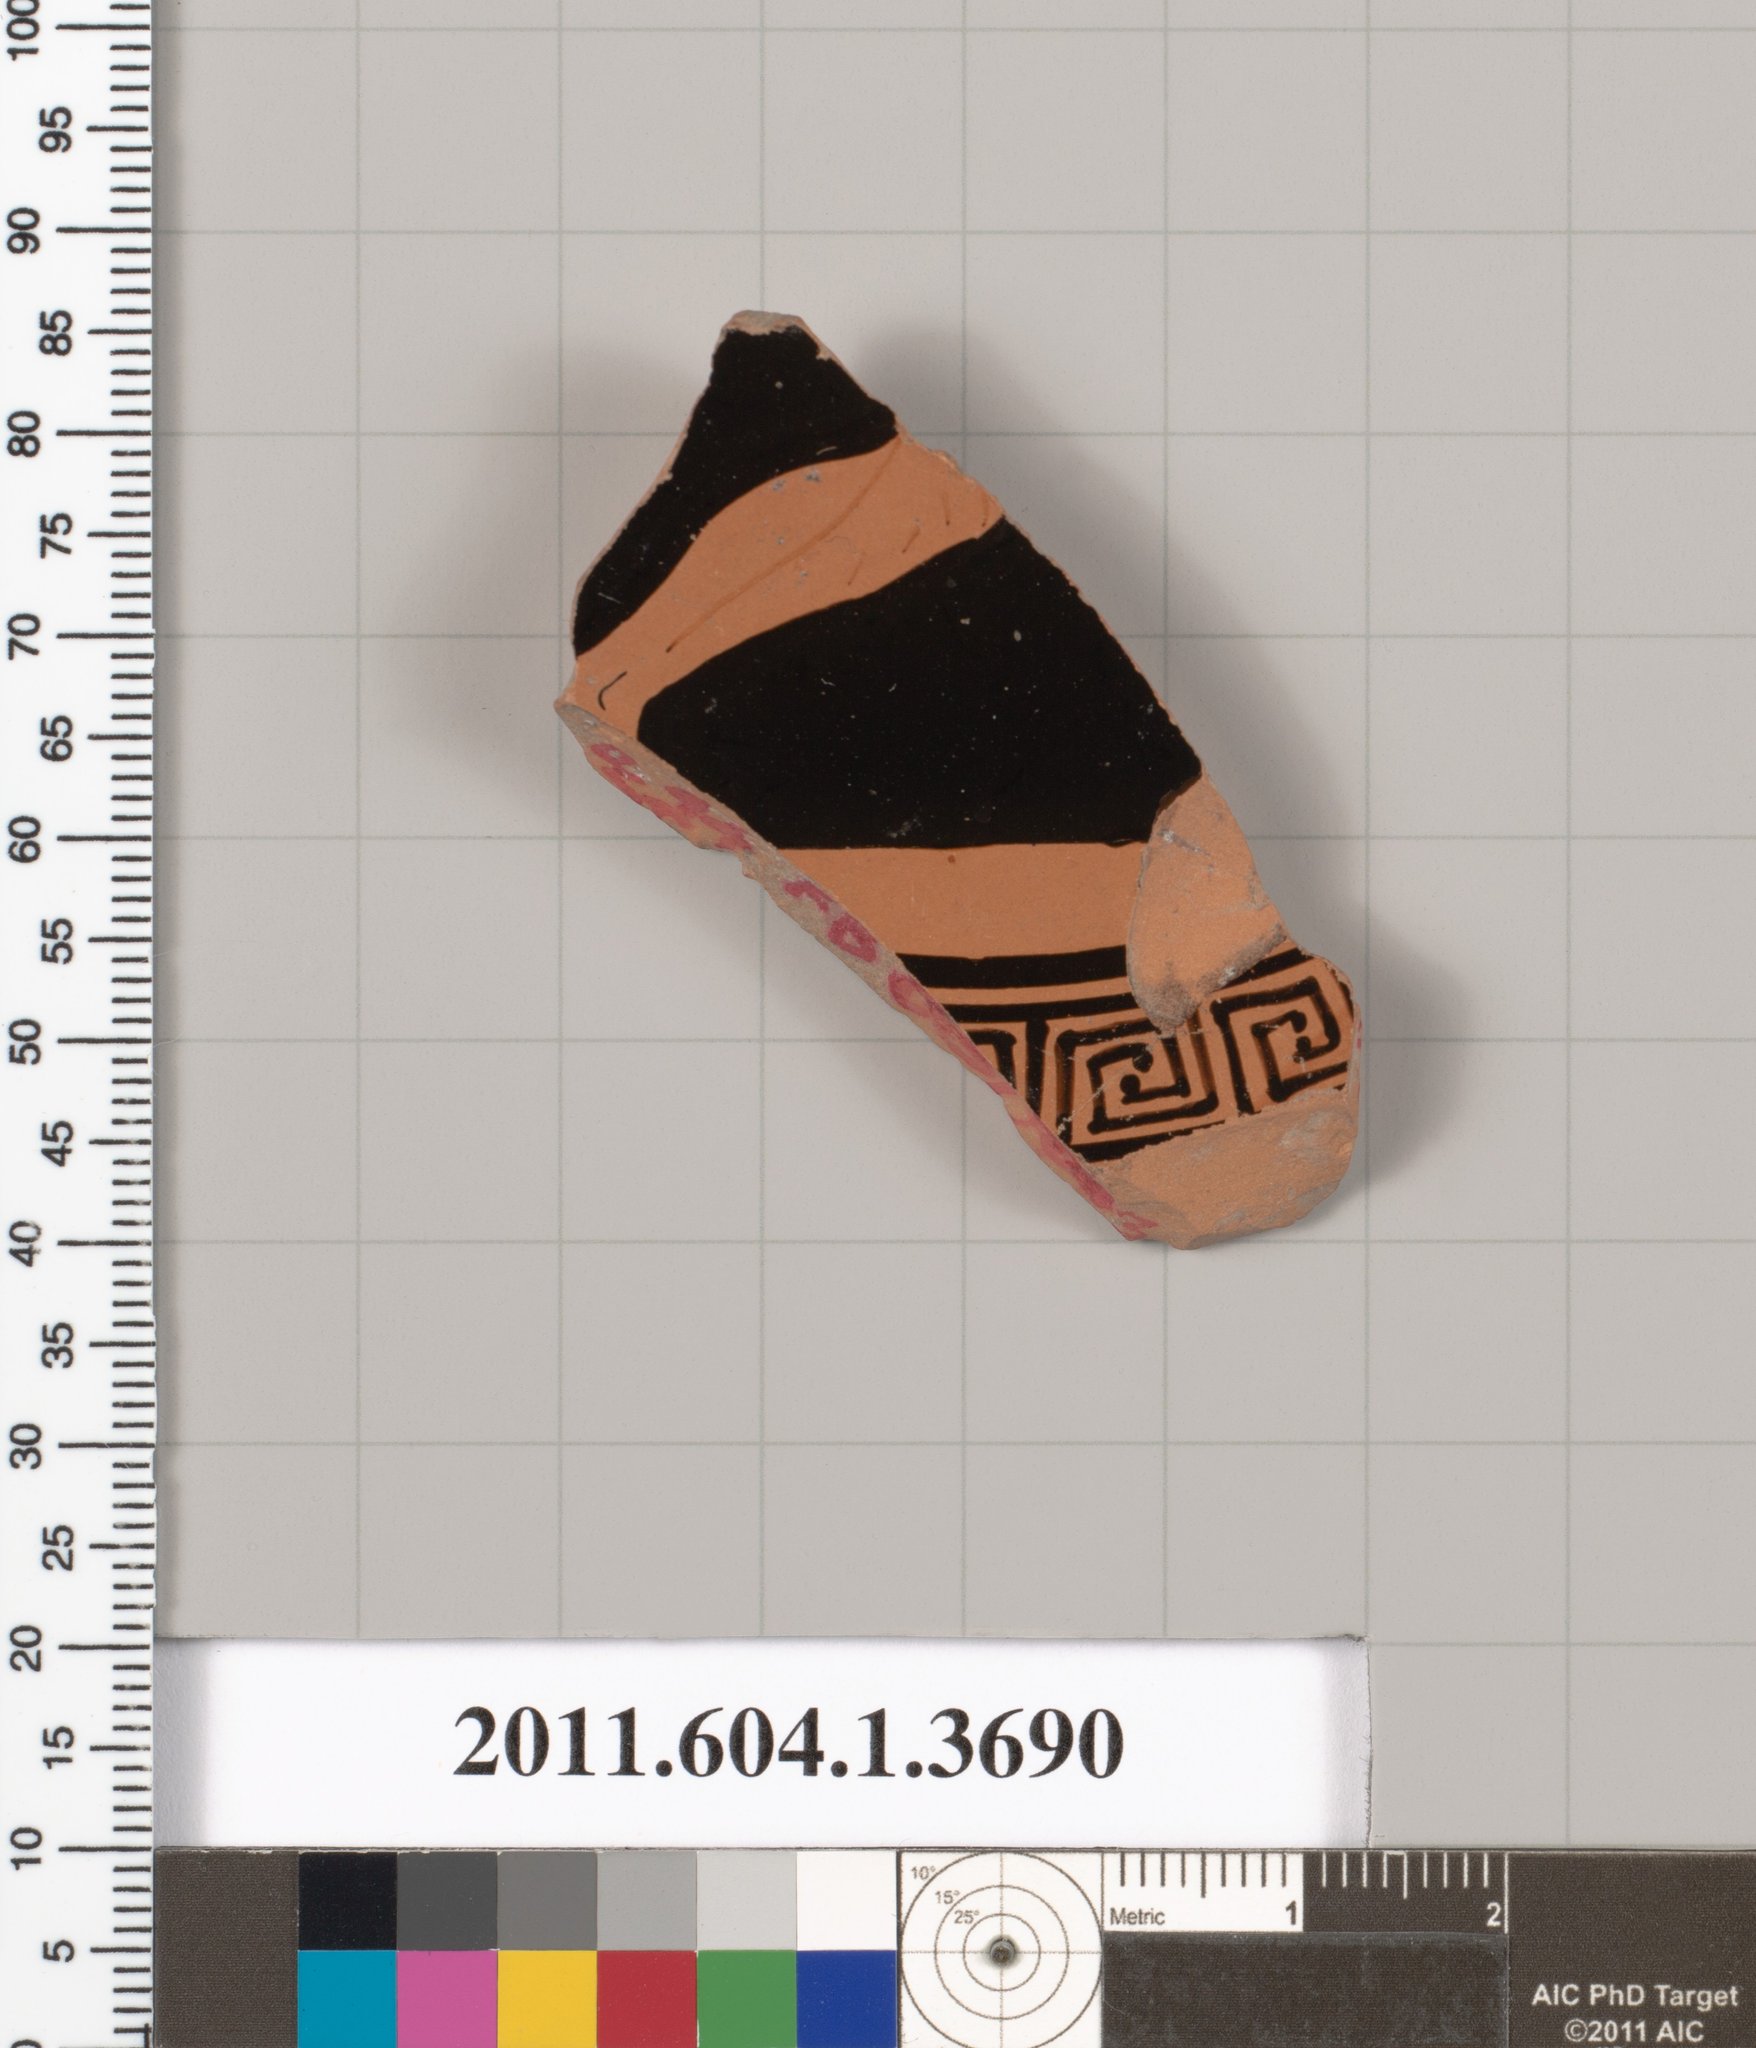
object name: kylix fragment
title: Terracotta fragment of a kylix (drinking cup)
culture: greek, attic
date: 500-470 BCE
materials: terracotta